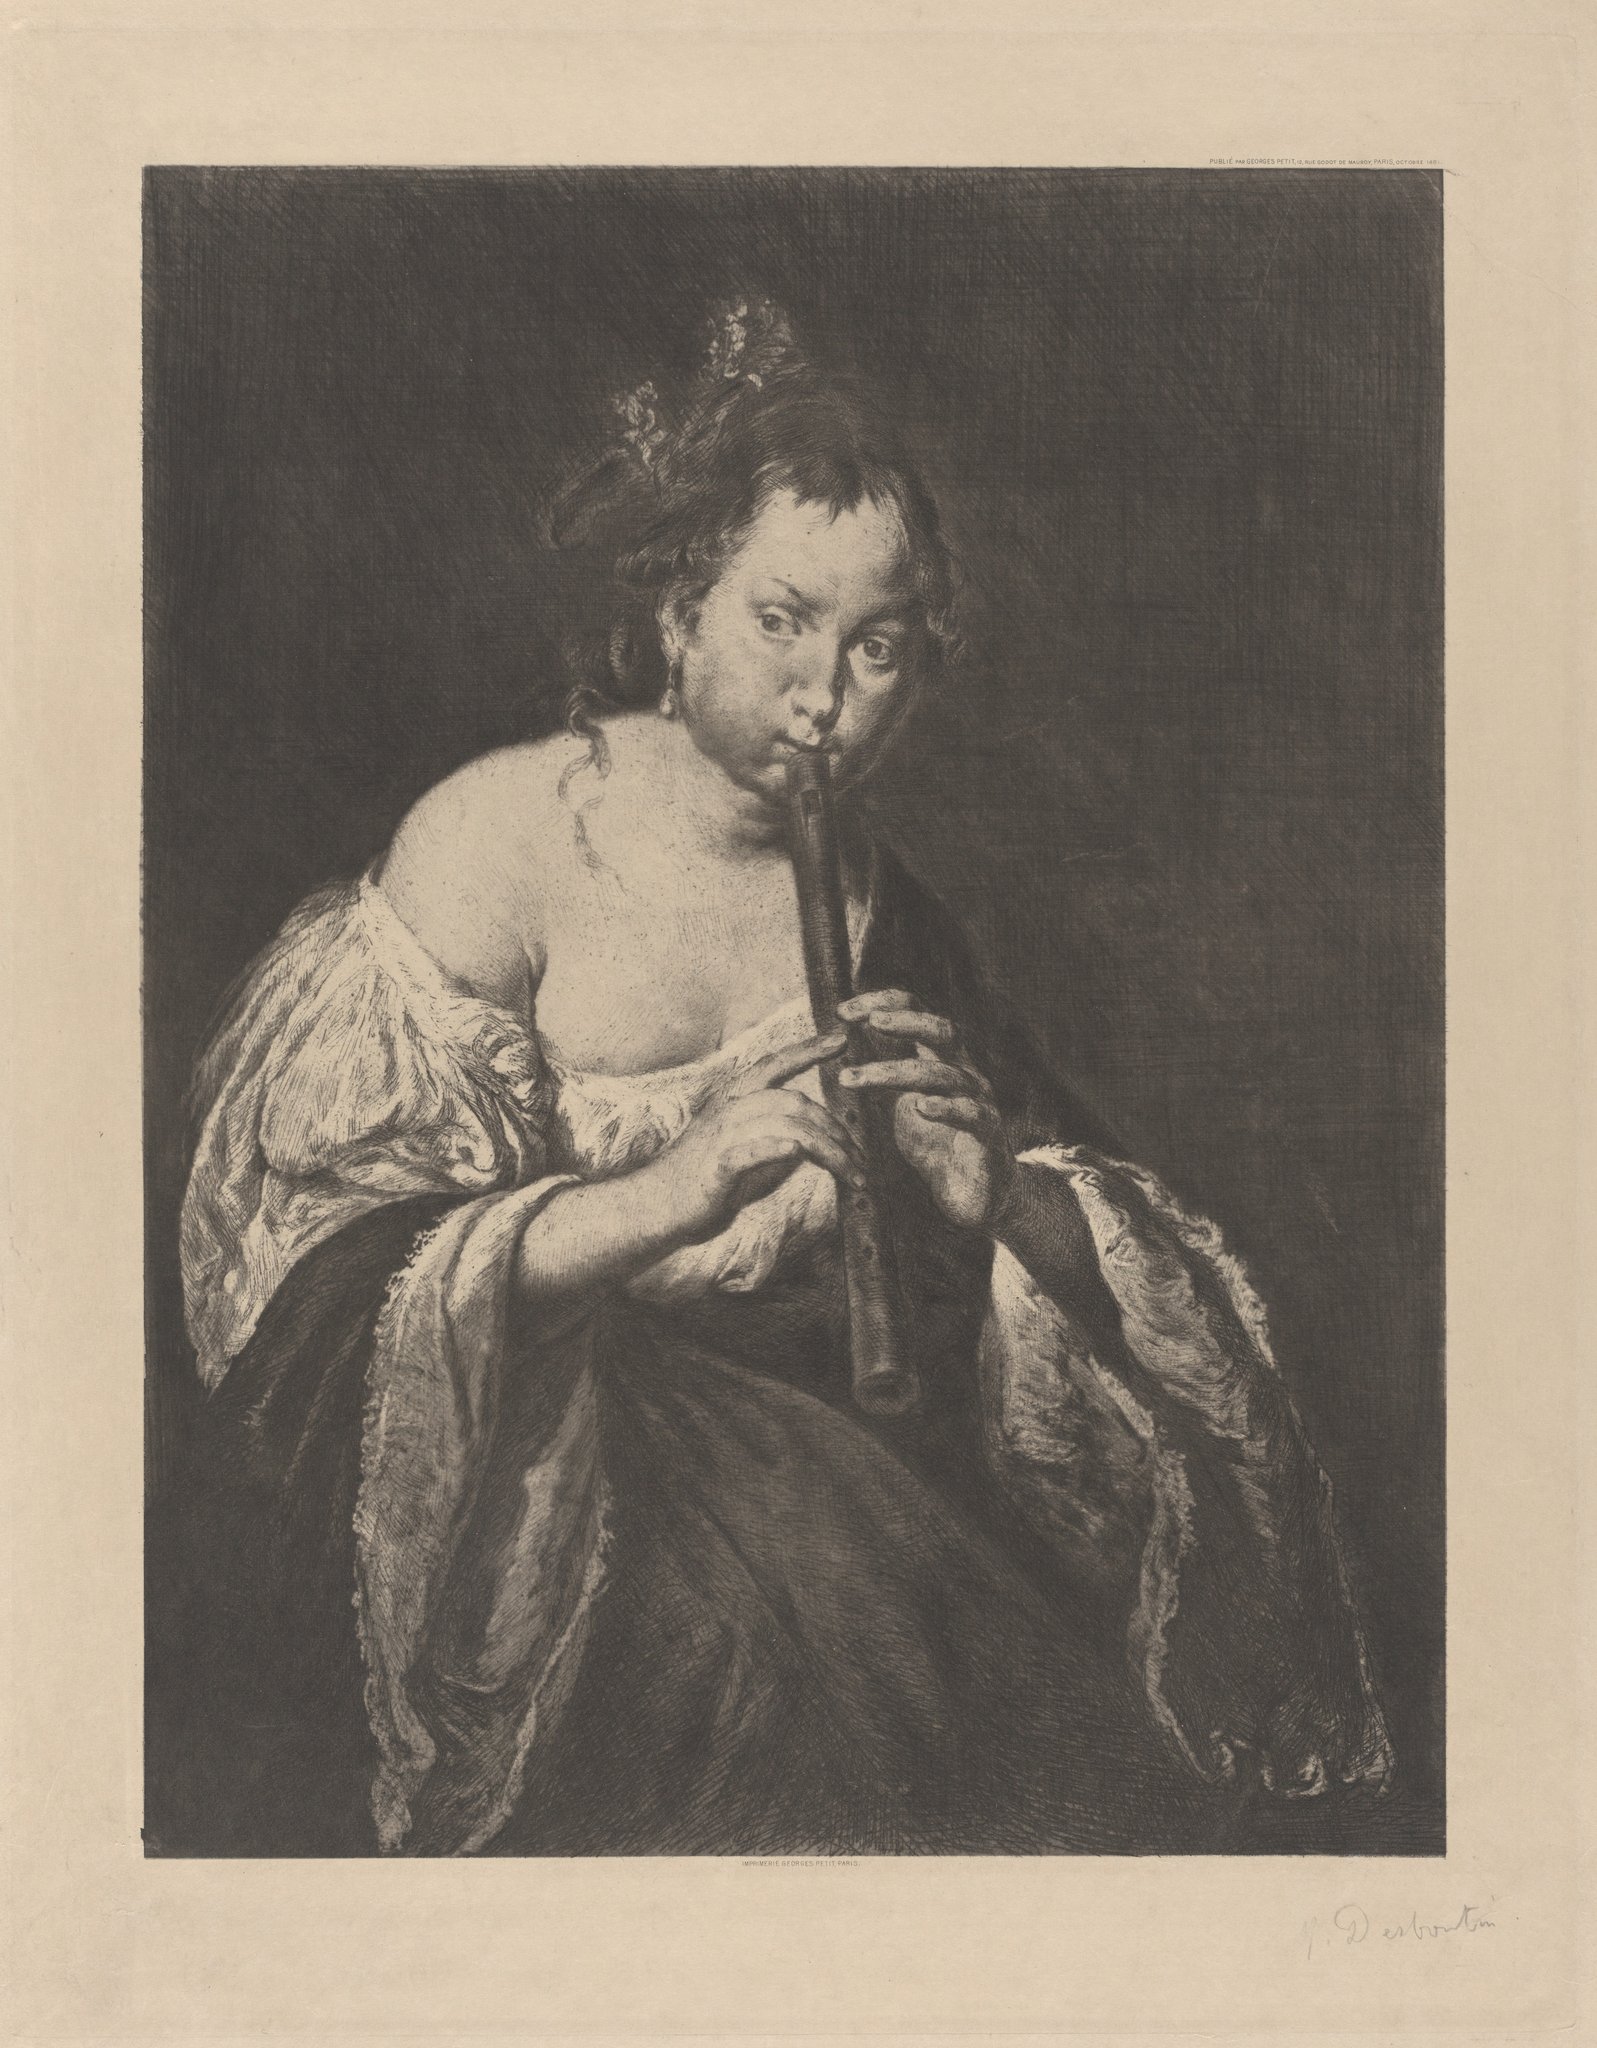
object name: print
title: La Flutiste, d'après Domenico Fetti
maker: marcellin desboutin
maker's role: artist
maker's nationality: french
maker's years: 1823-1902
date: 1891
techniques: etching, photogravure, roulette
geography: france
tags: women,flutes,musicians